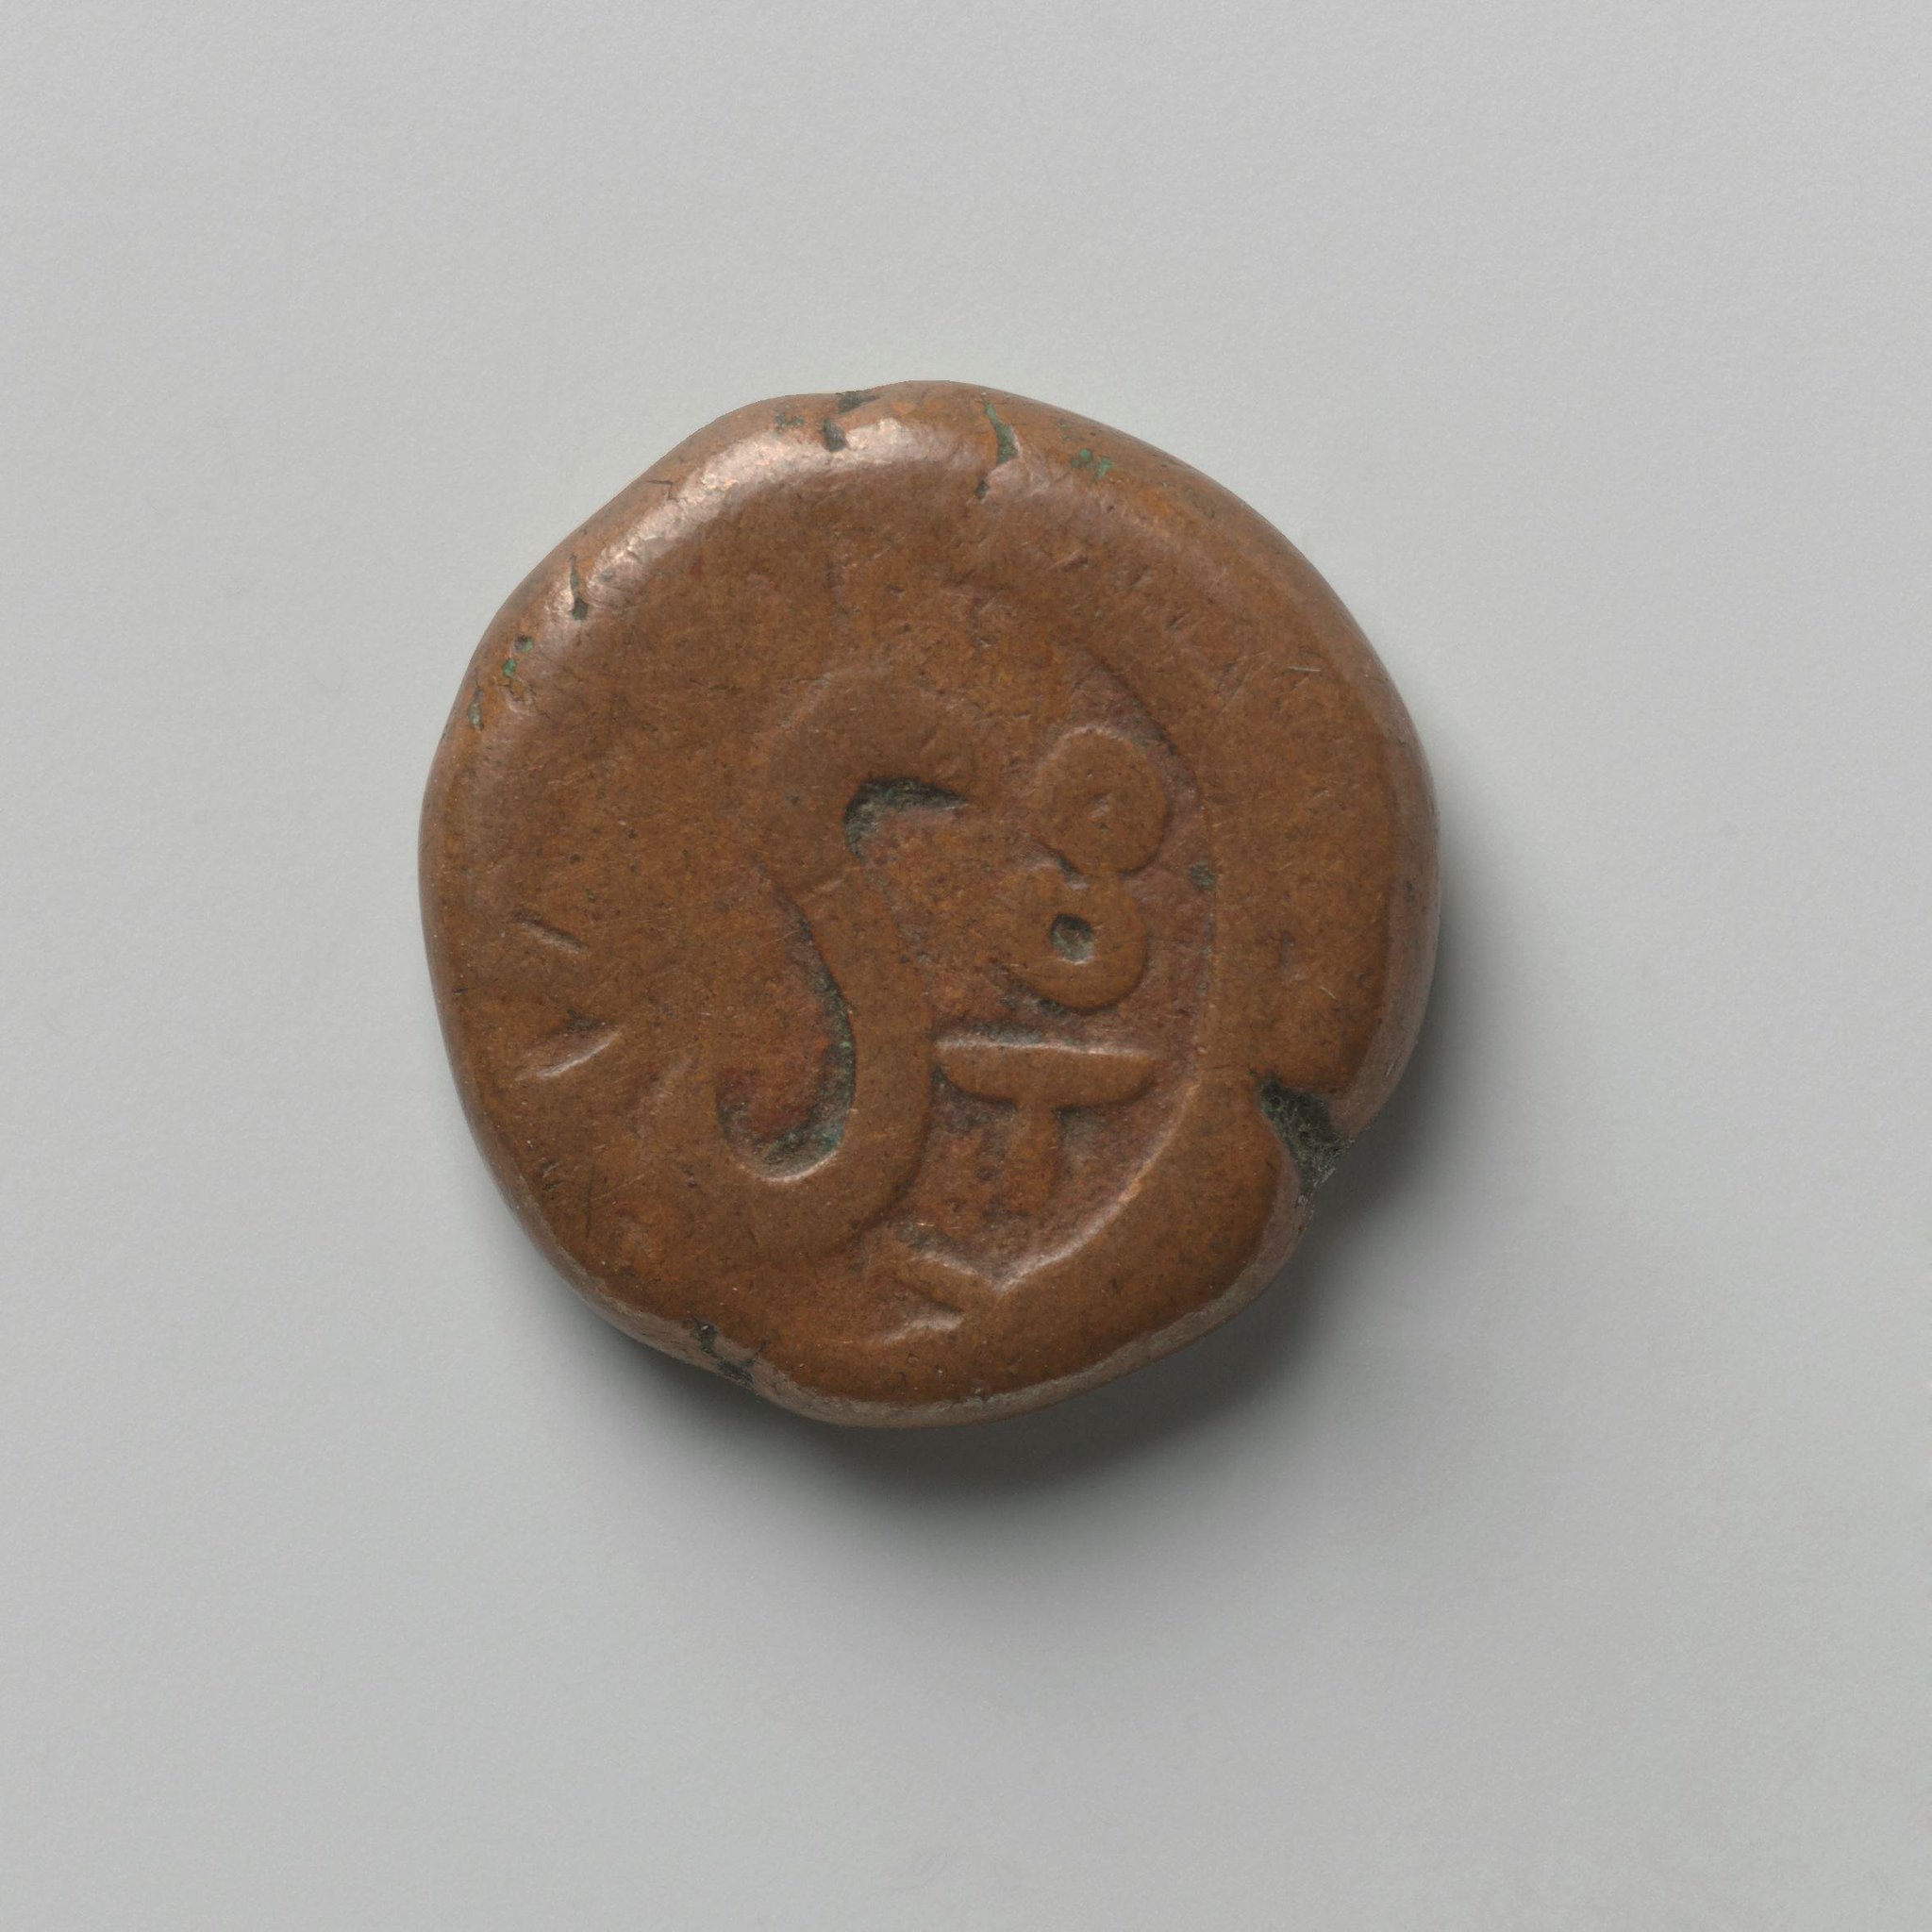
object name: coin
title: 1/8 stuiver van Ceylon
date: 1680-1710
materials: copper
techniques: striking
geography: jaffna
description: Koperen munt. Voorzijde: in een doornenkroon waarde-aanduiding 1/8 St (t omgekeeerd). Keerzijde: in een doornenkroon waarde-aanduiding 1/8 St (t omgekeerd). Gladde rand.